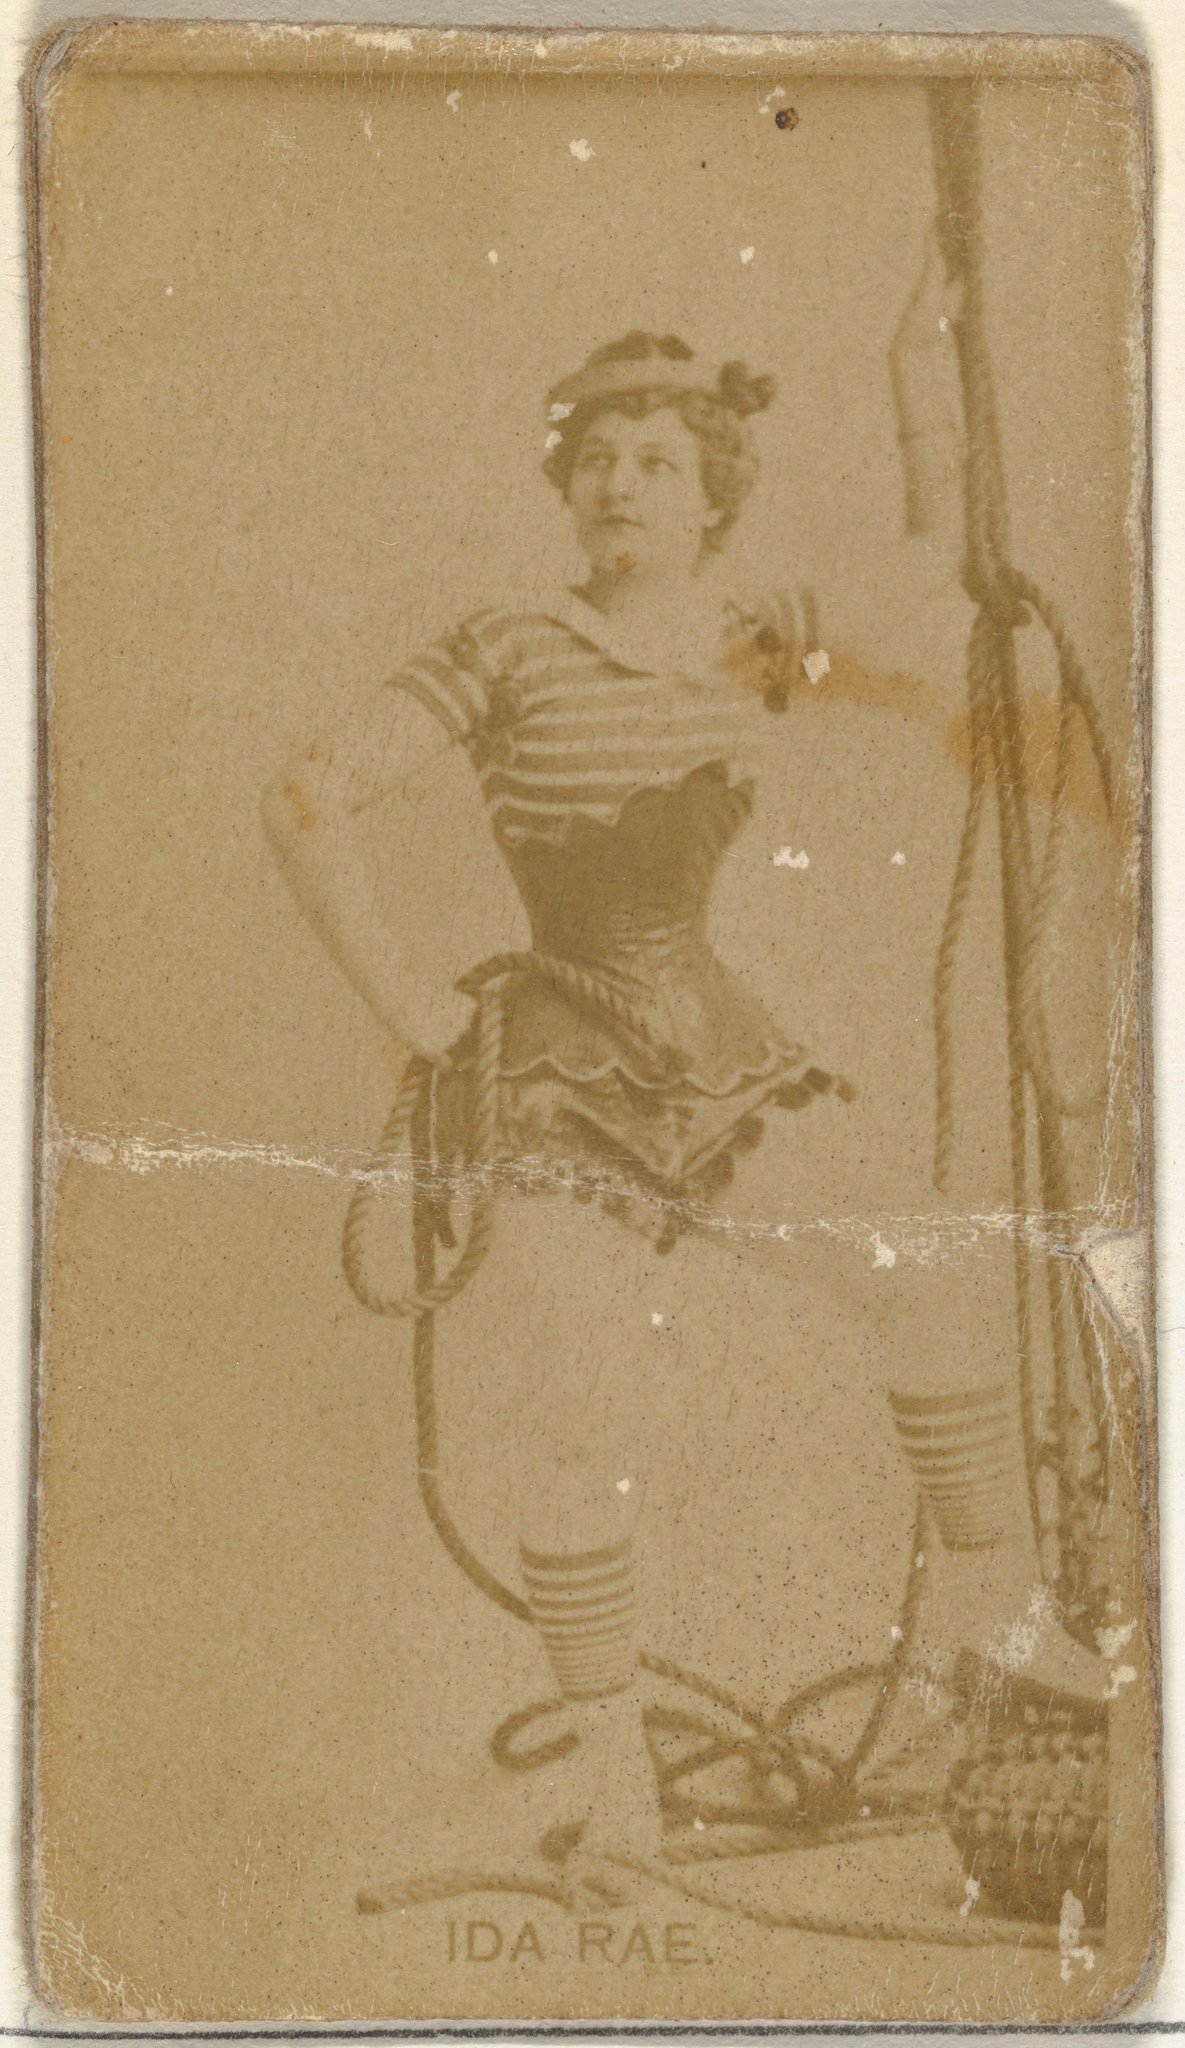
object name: photograph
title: Ida Rae, from the Actors and Actresses series (N145-8) issued by Duke Sons & Co. to promote Duke Cigarettes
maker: w. duke, sons & co.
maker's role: publisher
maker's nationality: american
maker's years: 1870-1920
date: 1891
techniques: albumen silver print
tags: portraits,women,actresses